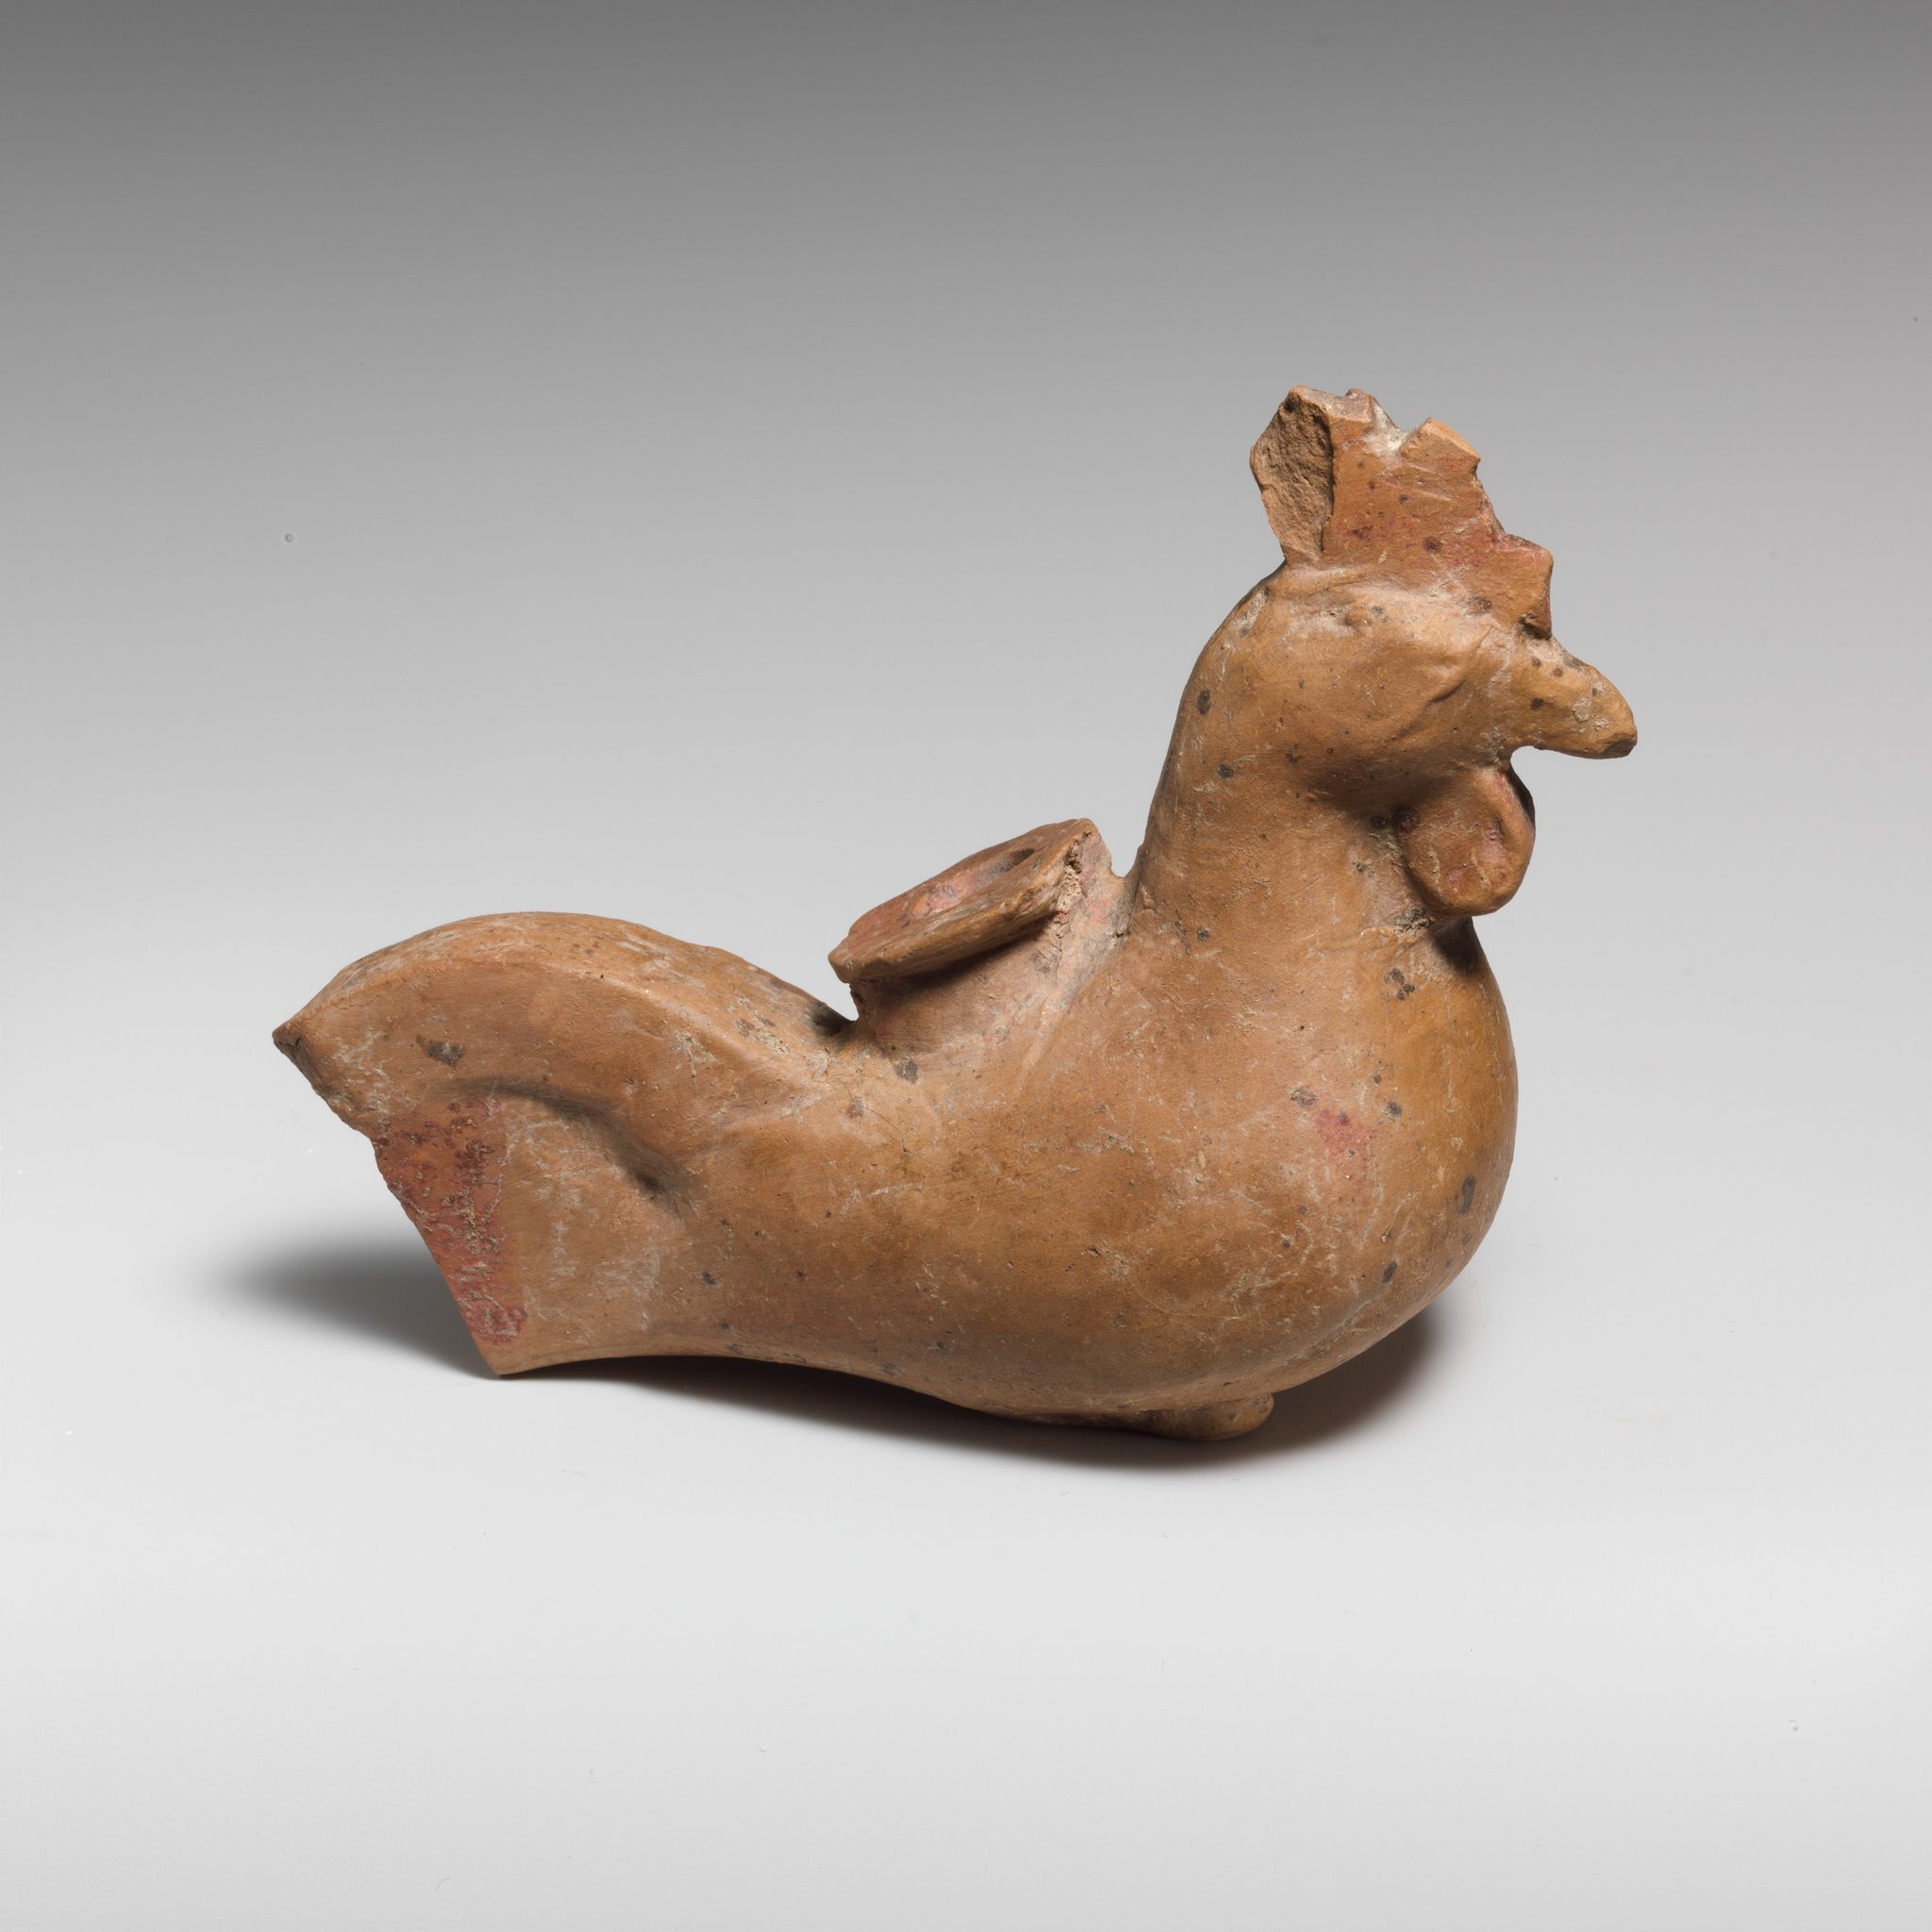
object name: aryballos in the form of a rooster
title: Terracotta vase in the form of a rooster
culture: east greek, rhodian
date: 534-501 BCE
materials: terracotta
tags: roosters